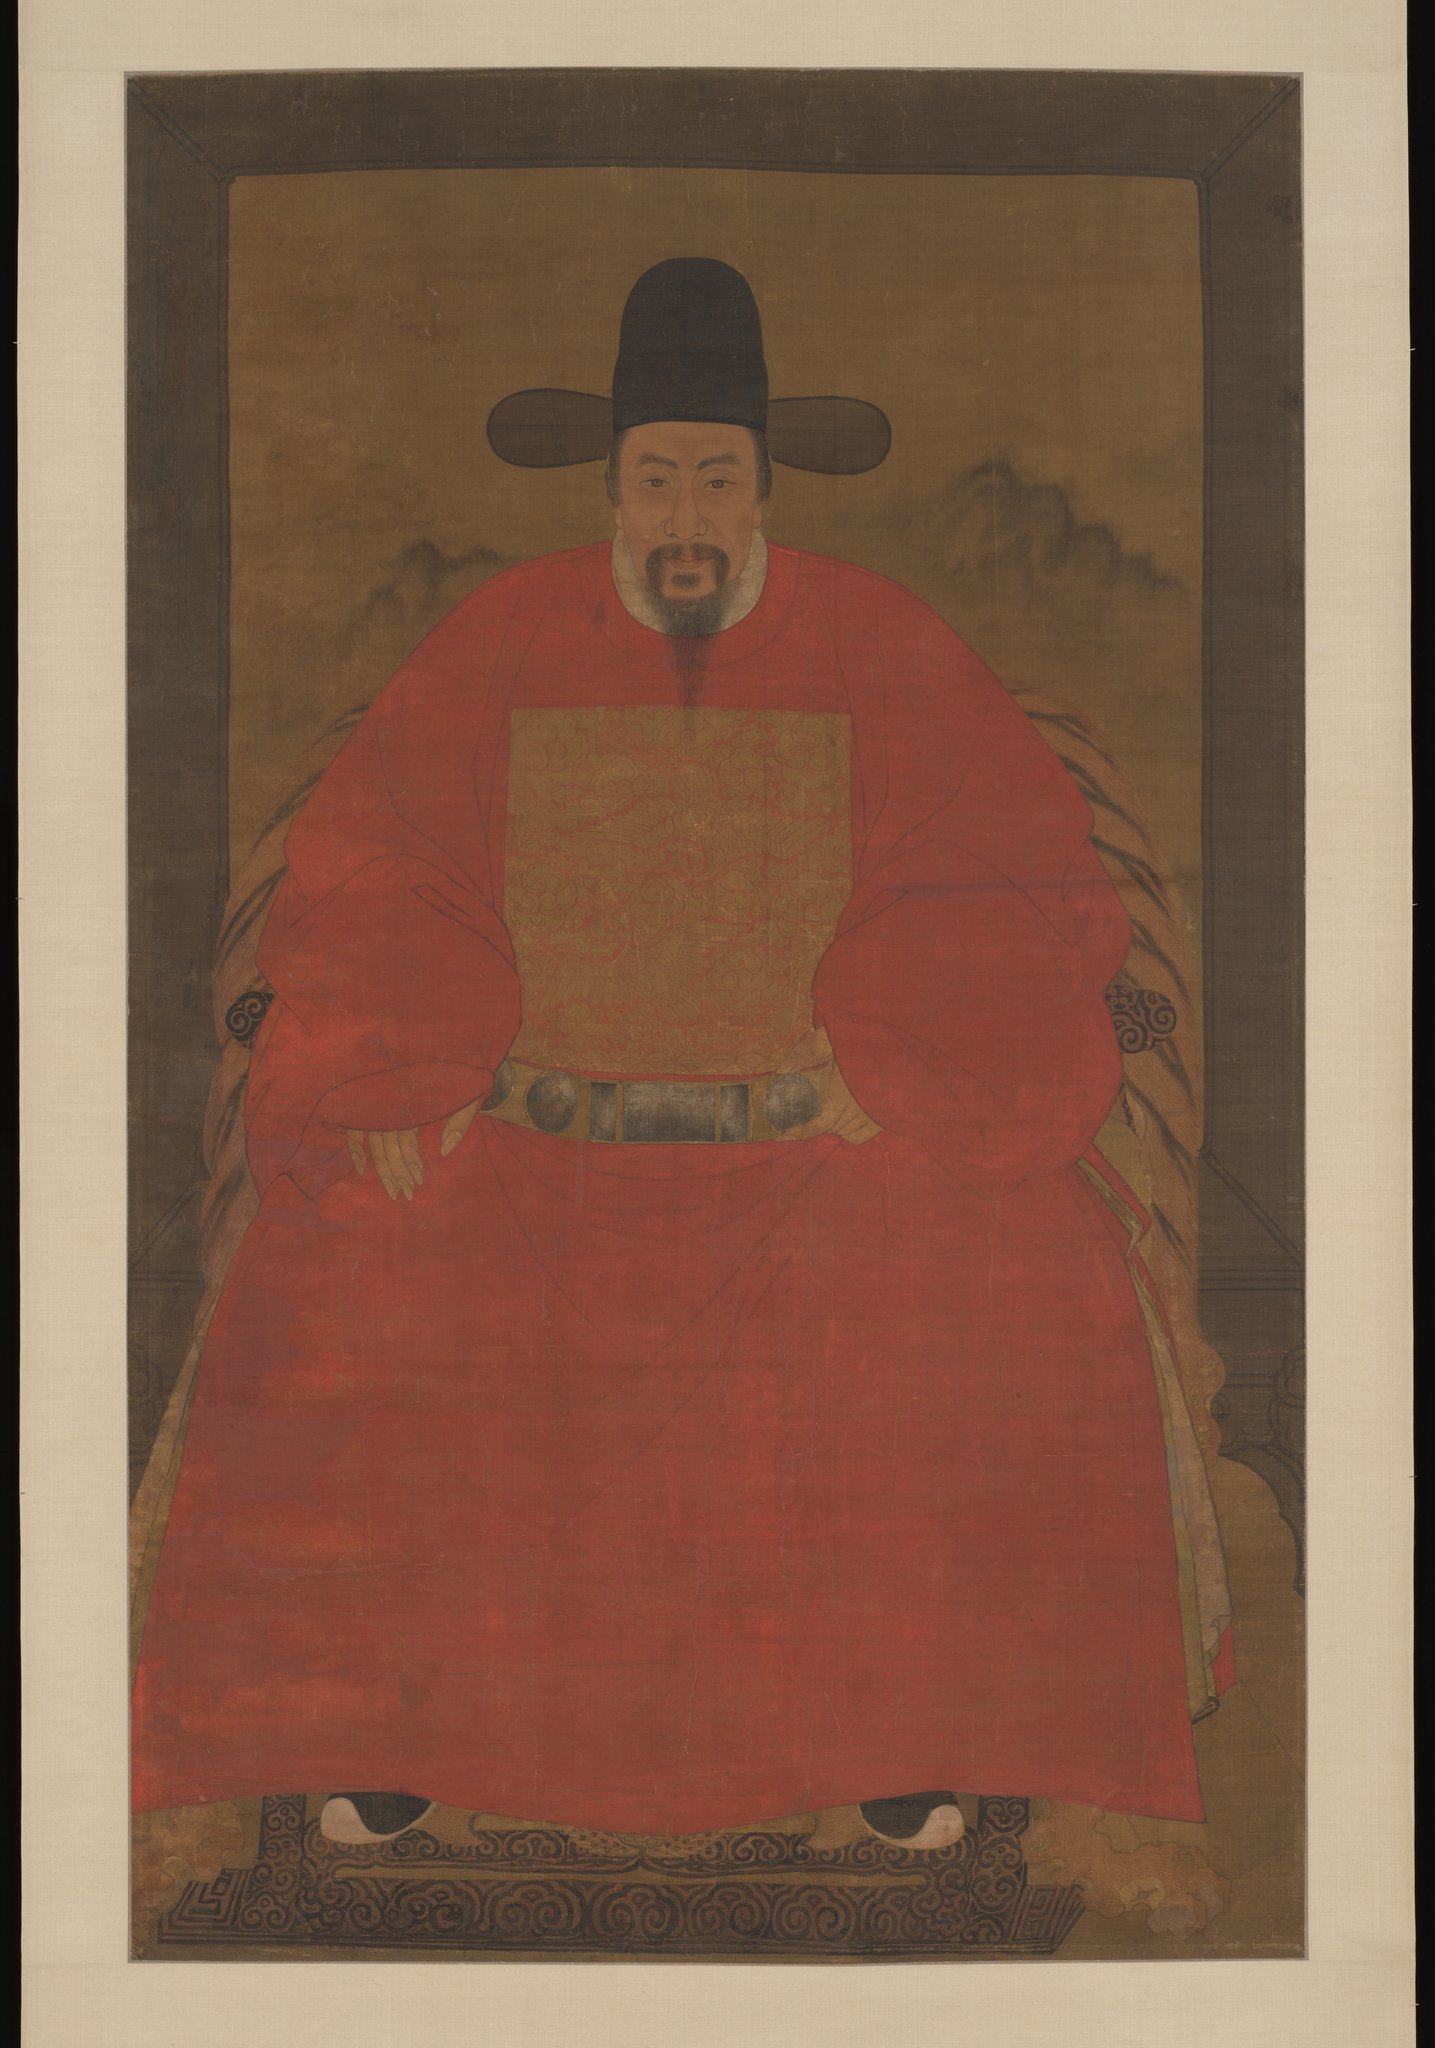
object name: hanging scroll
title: Portrait of a Gentleman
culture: chinese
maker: unidentified artist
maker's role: artist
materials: ink, silk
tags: men,portraits